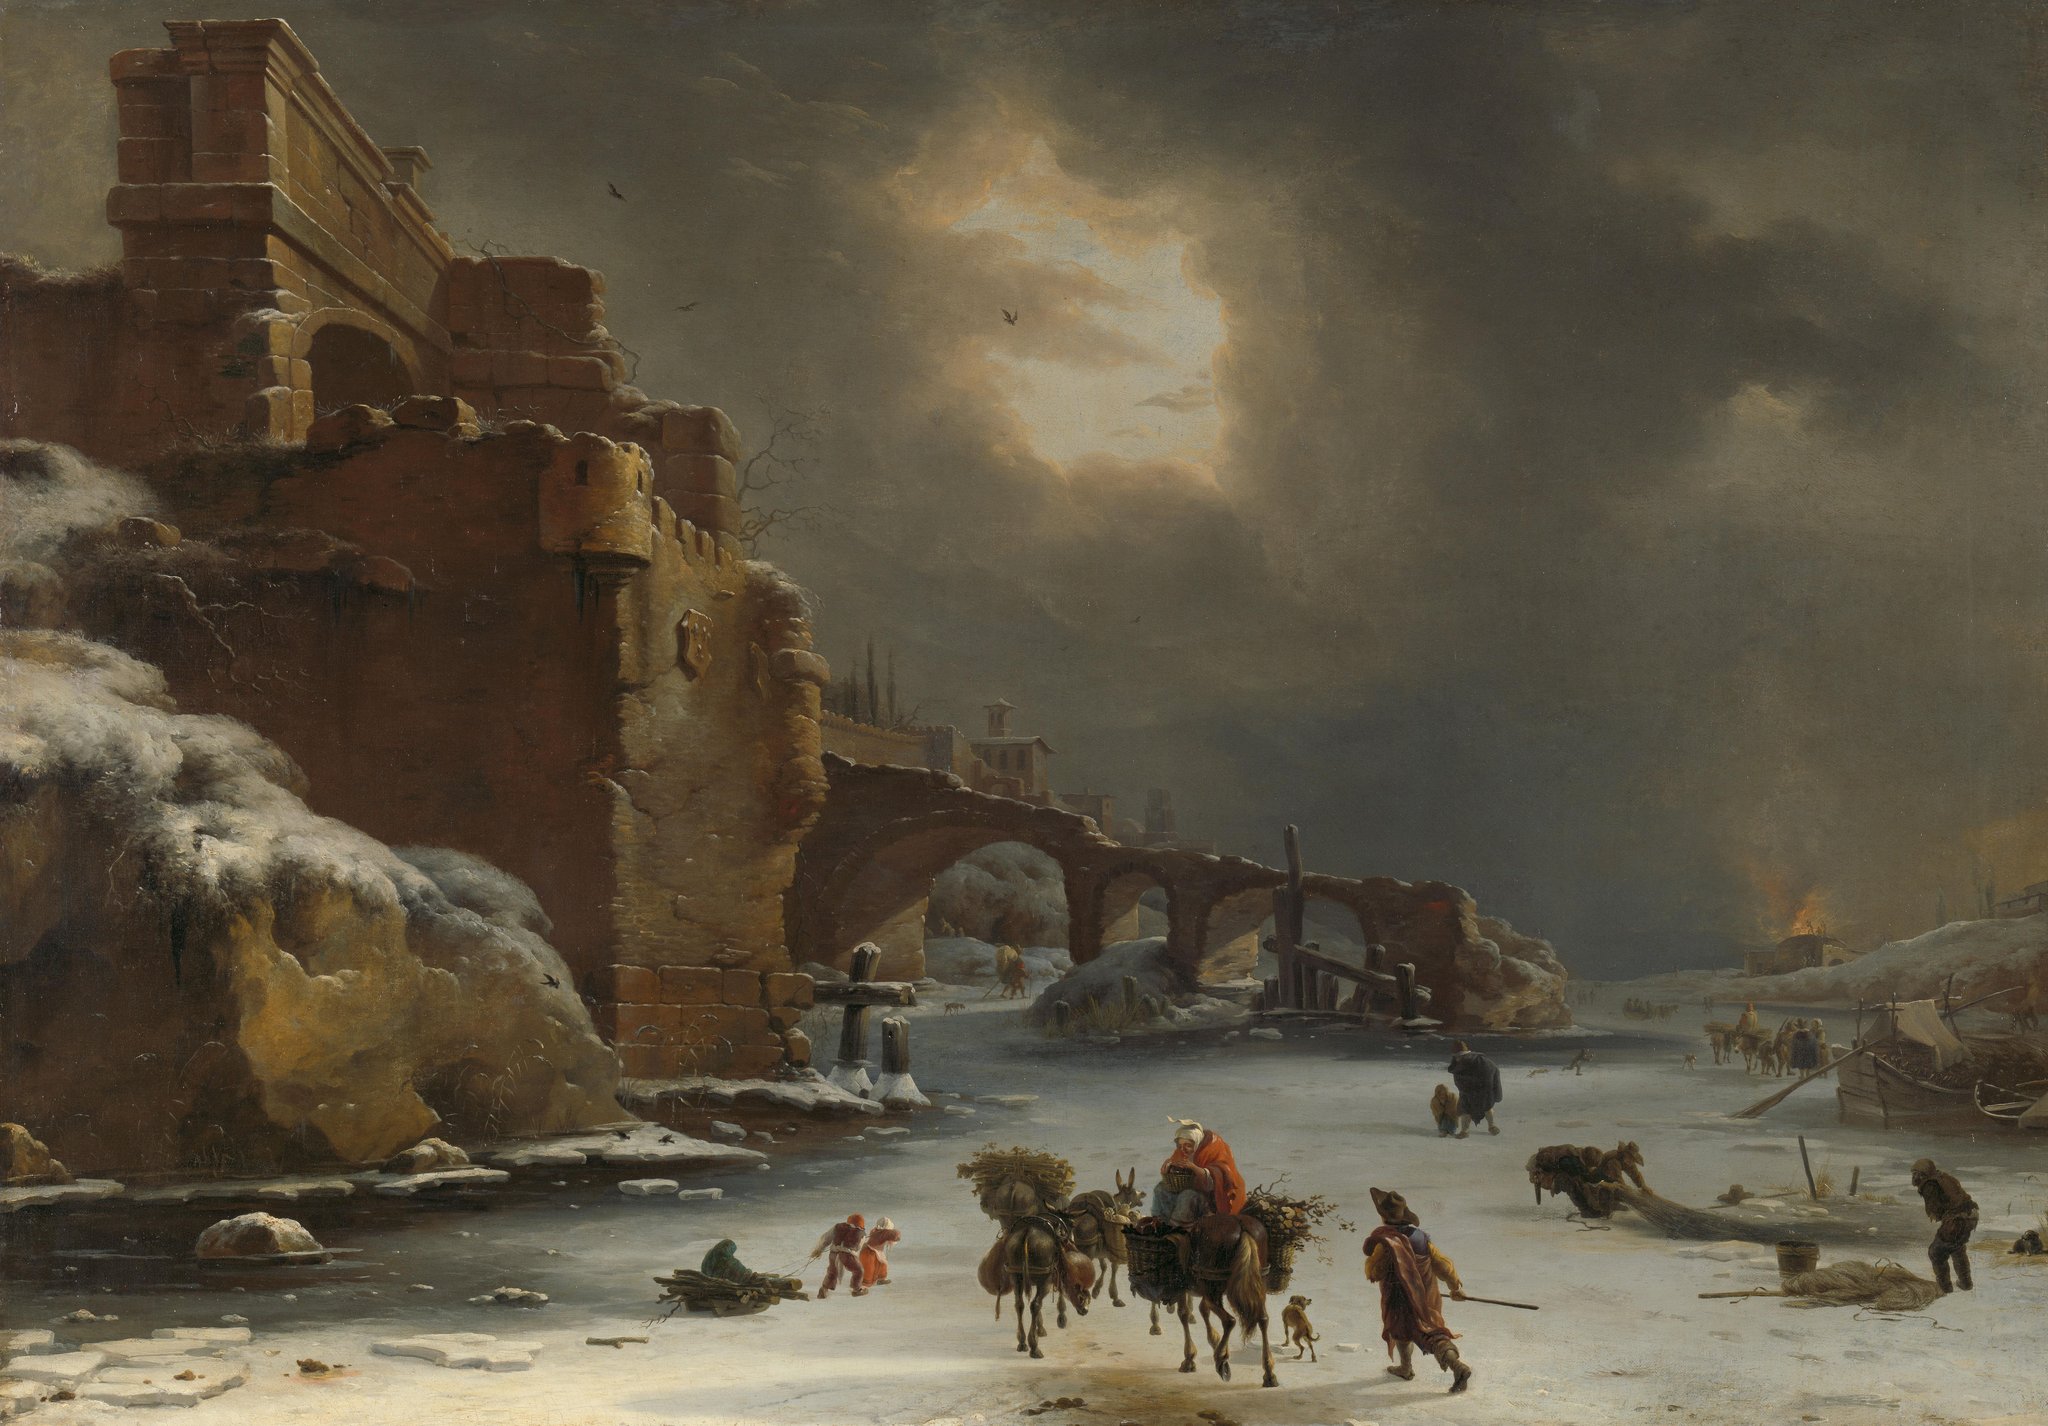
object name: painting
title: City Walls in Winter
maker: willem schellinks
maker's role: draughtsman, painter, print maker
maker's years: 1627-1678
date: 1650-1670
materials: canvas, oil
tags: riding a horse, ass, or mule; rider, horseman, landscape with ruins, sleigh, sledge (non-sport), ice ~ freezing weather, city-walls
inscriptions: signature: ‘WS’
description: A canal running alongside a fortified city disappears into the distance, the city walls in ruins and the bridge collapsed. In the background at right is a glowing furnace, where marble is burned to make chalk. These motifs, often found in paintings by Dutch Italianates, have here been shifted to a cold wintery day.